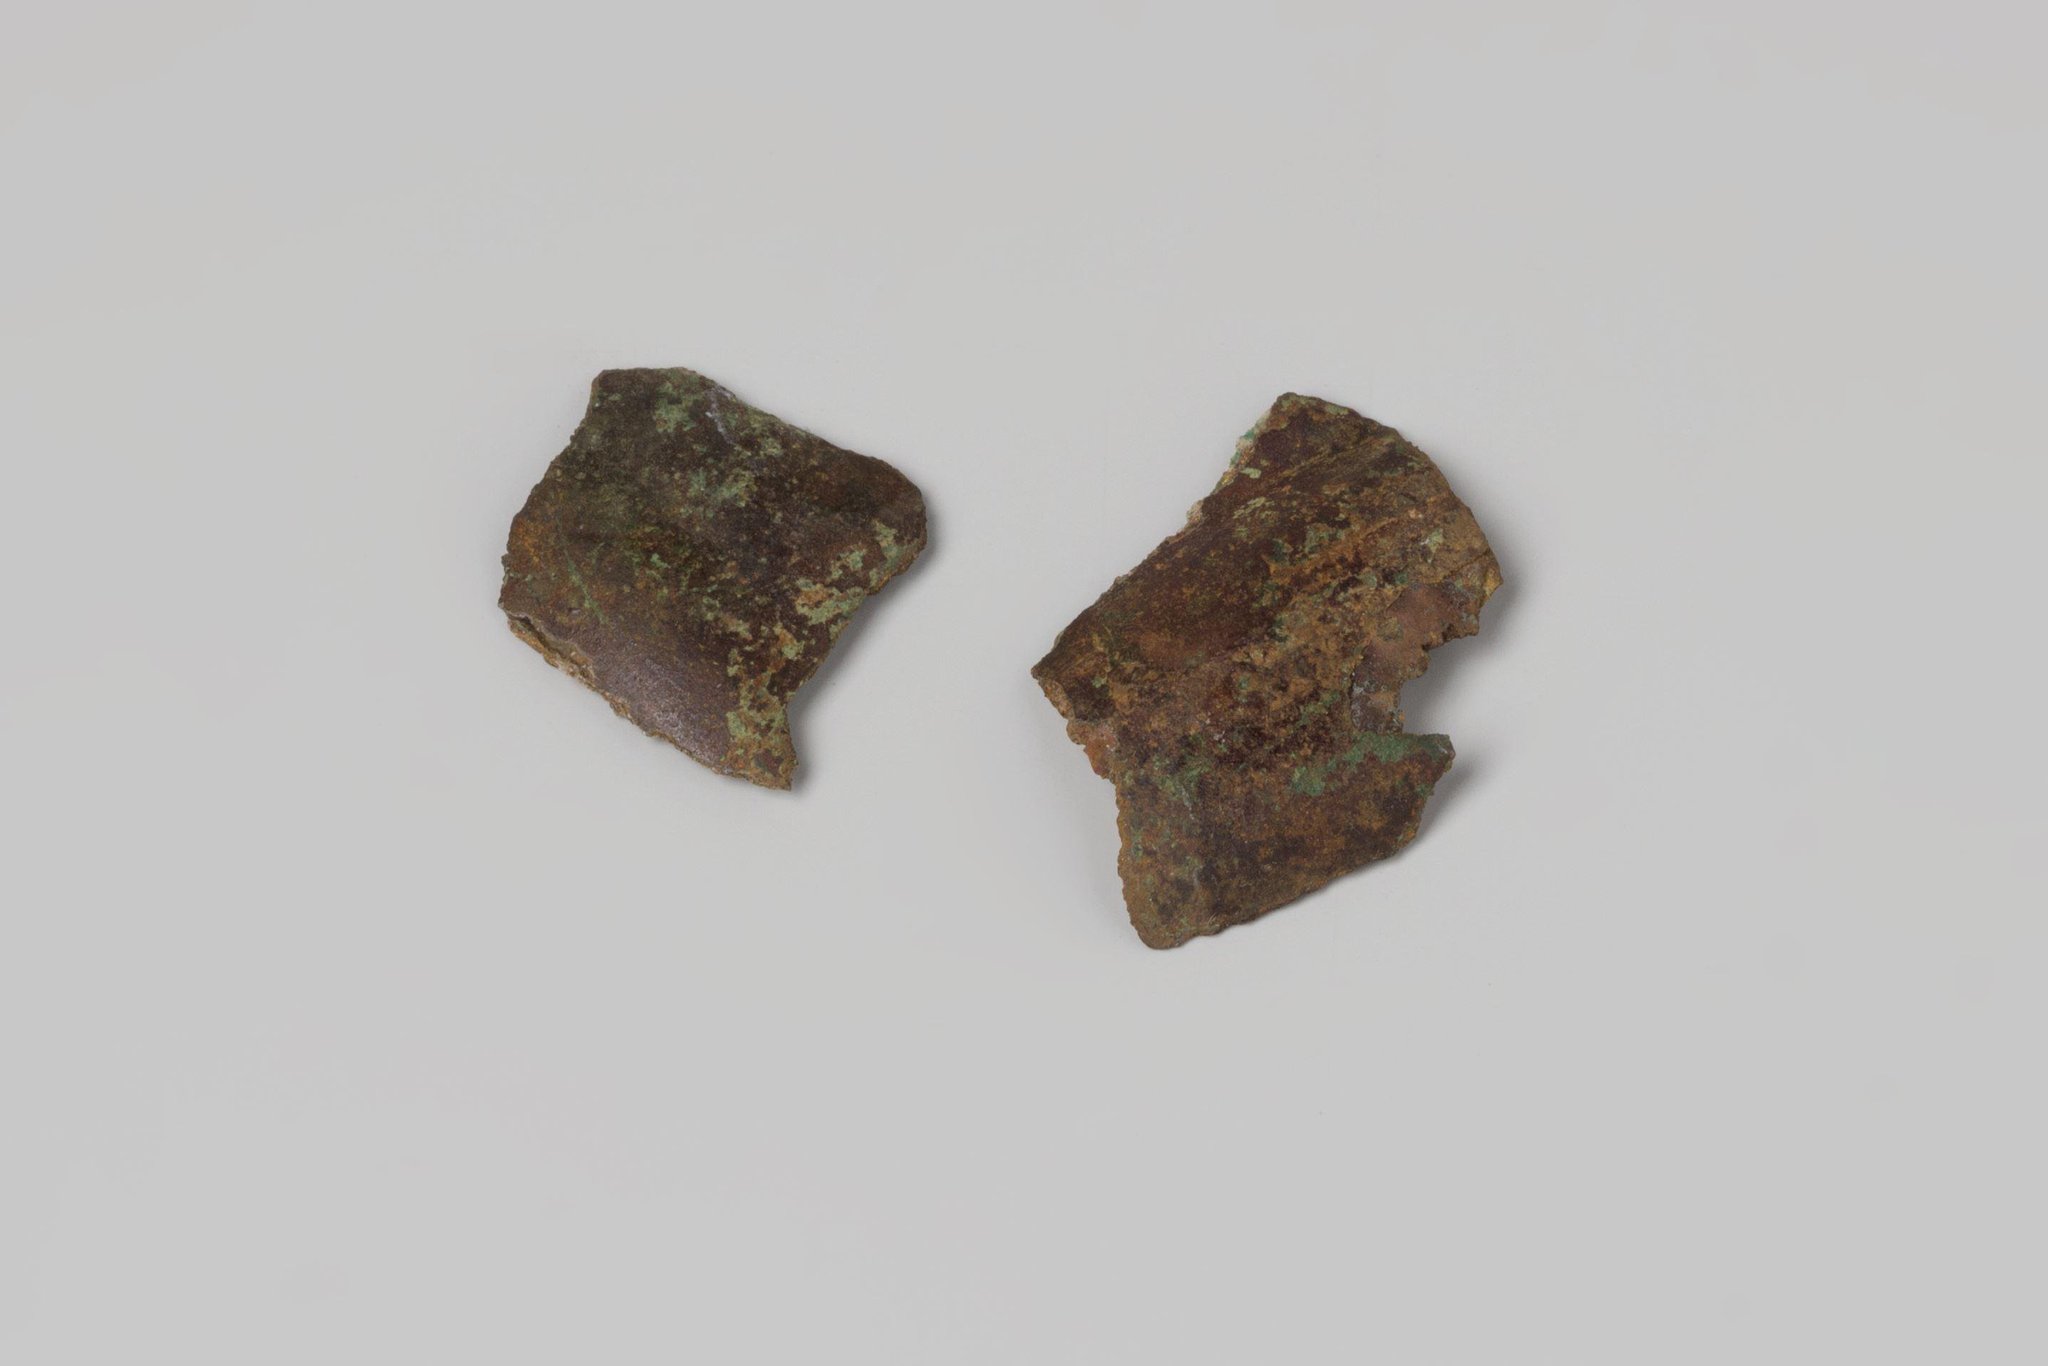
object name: fragment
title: Fragmenten koper uit het wrak van de Oost-Indiëvaarder Hollandia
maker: Anonymous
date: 1700-1743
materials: copper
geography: netherlands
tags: verenigde oostindische compagnie, hollandia (schip), annet